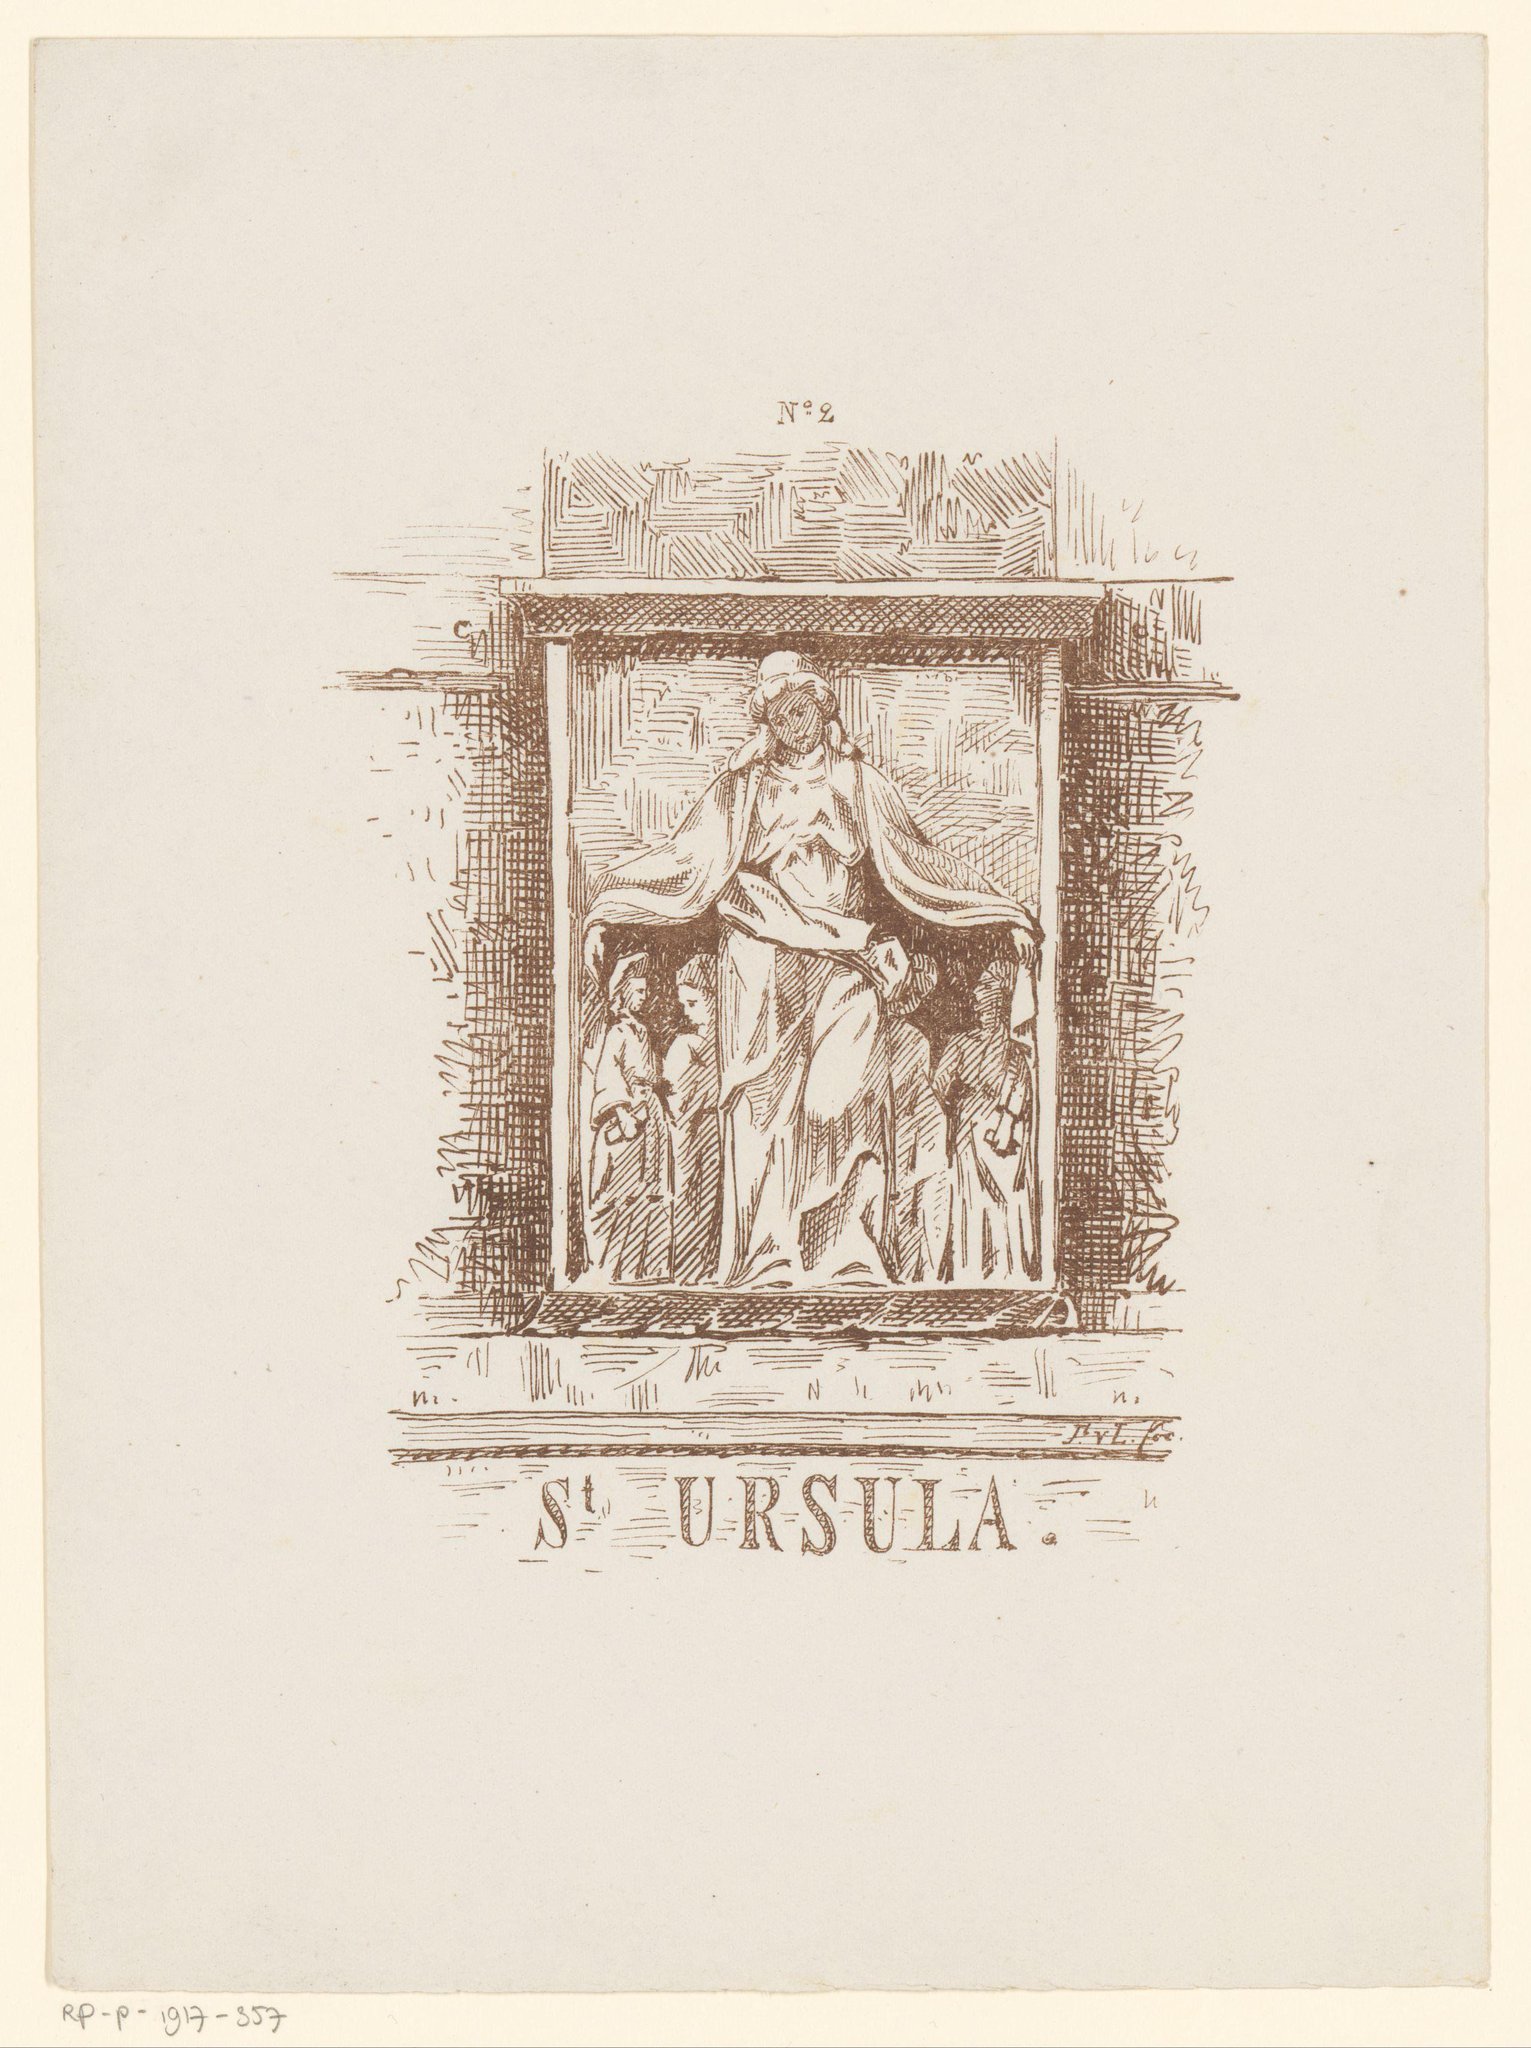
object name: print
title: Gevelsteen met de heilige Ursula Begijnhof in Amsterdam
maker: jac van looij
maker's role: draughtsman, painter, print maker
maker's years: 1855-1930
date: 1877-1894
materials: paper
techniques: lithograph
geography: amsterdam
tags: stone tablet in façade, st. ursula protecting the eleven thousand virgins with her cloak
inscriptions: collector's mark: Lugt 2228